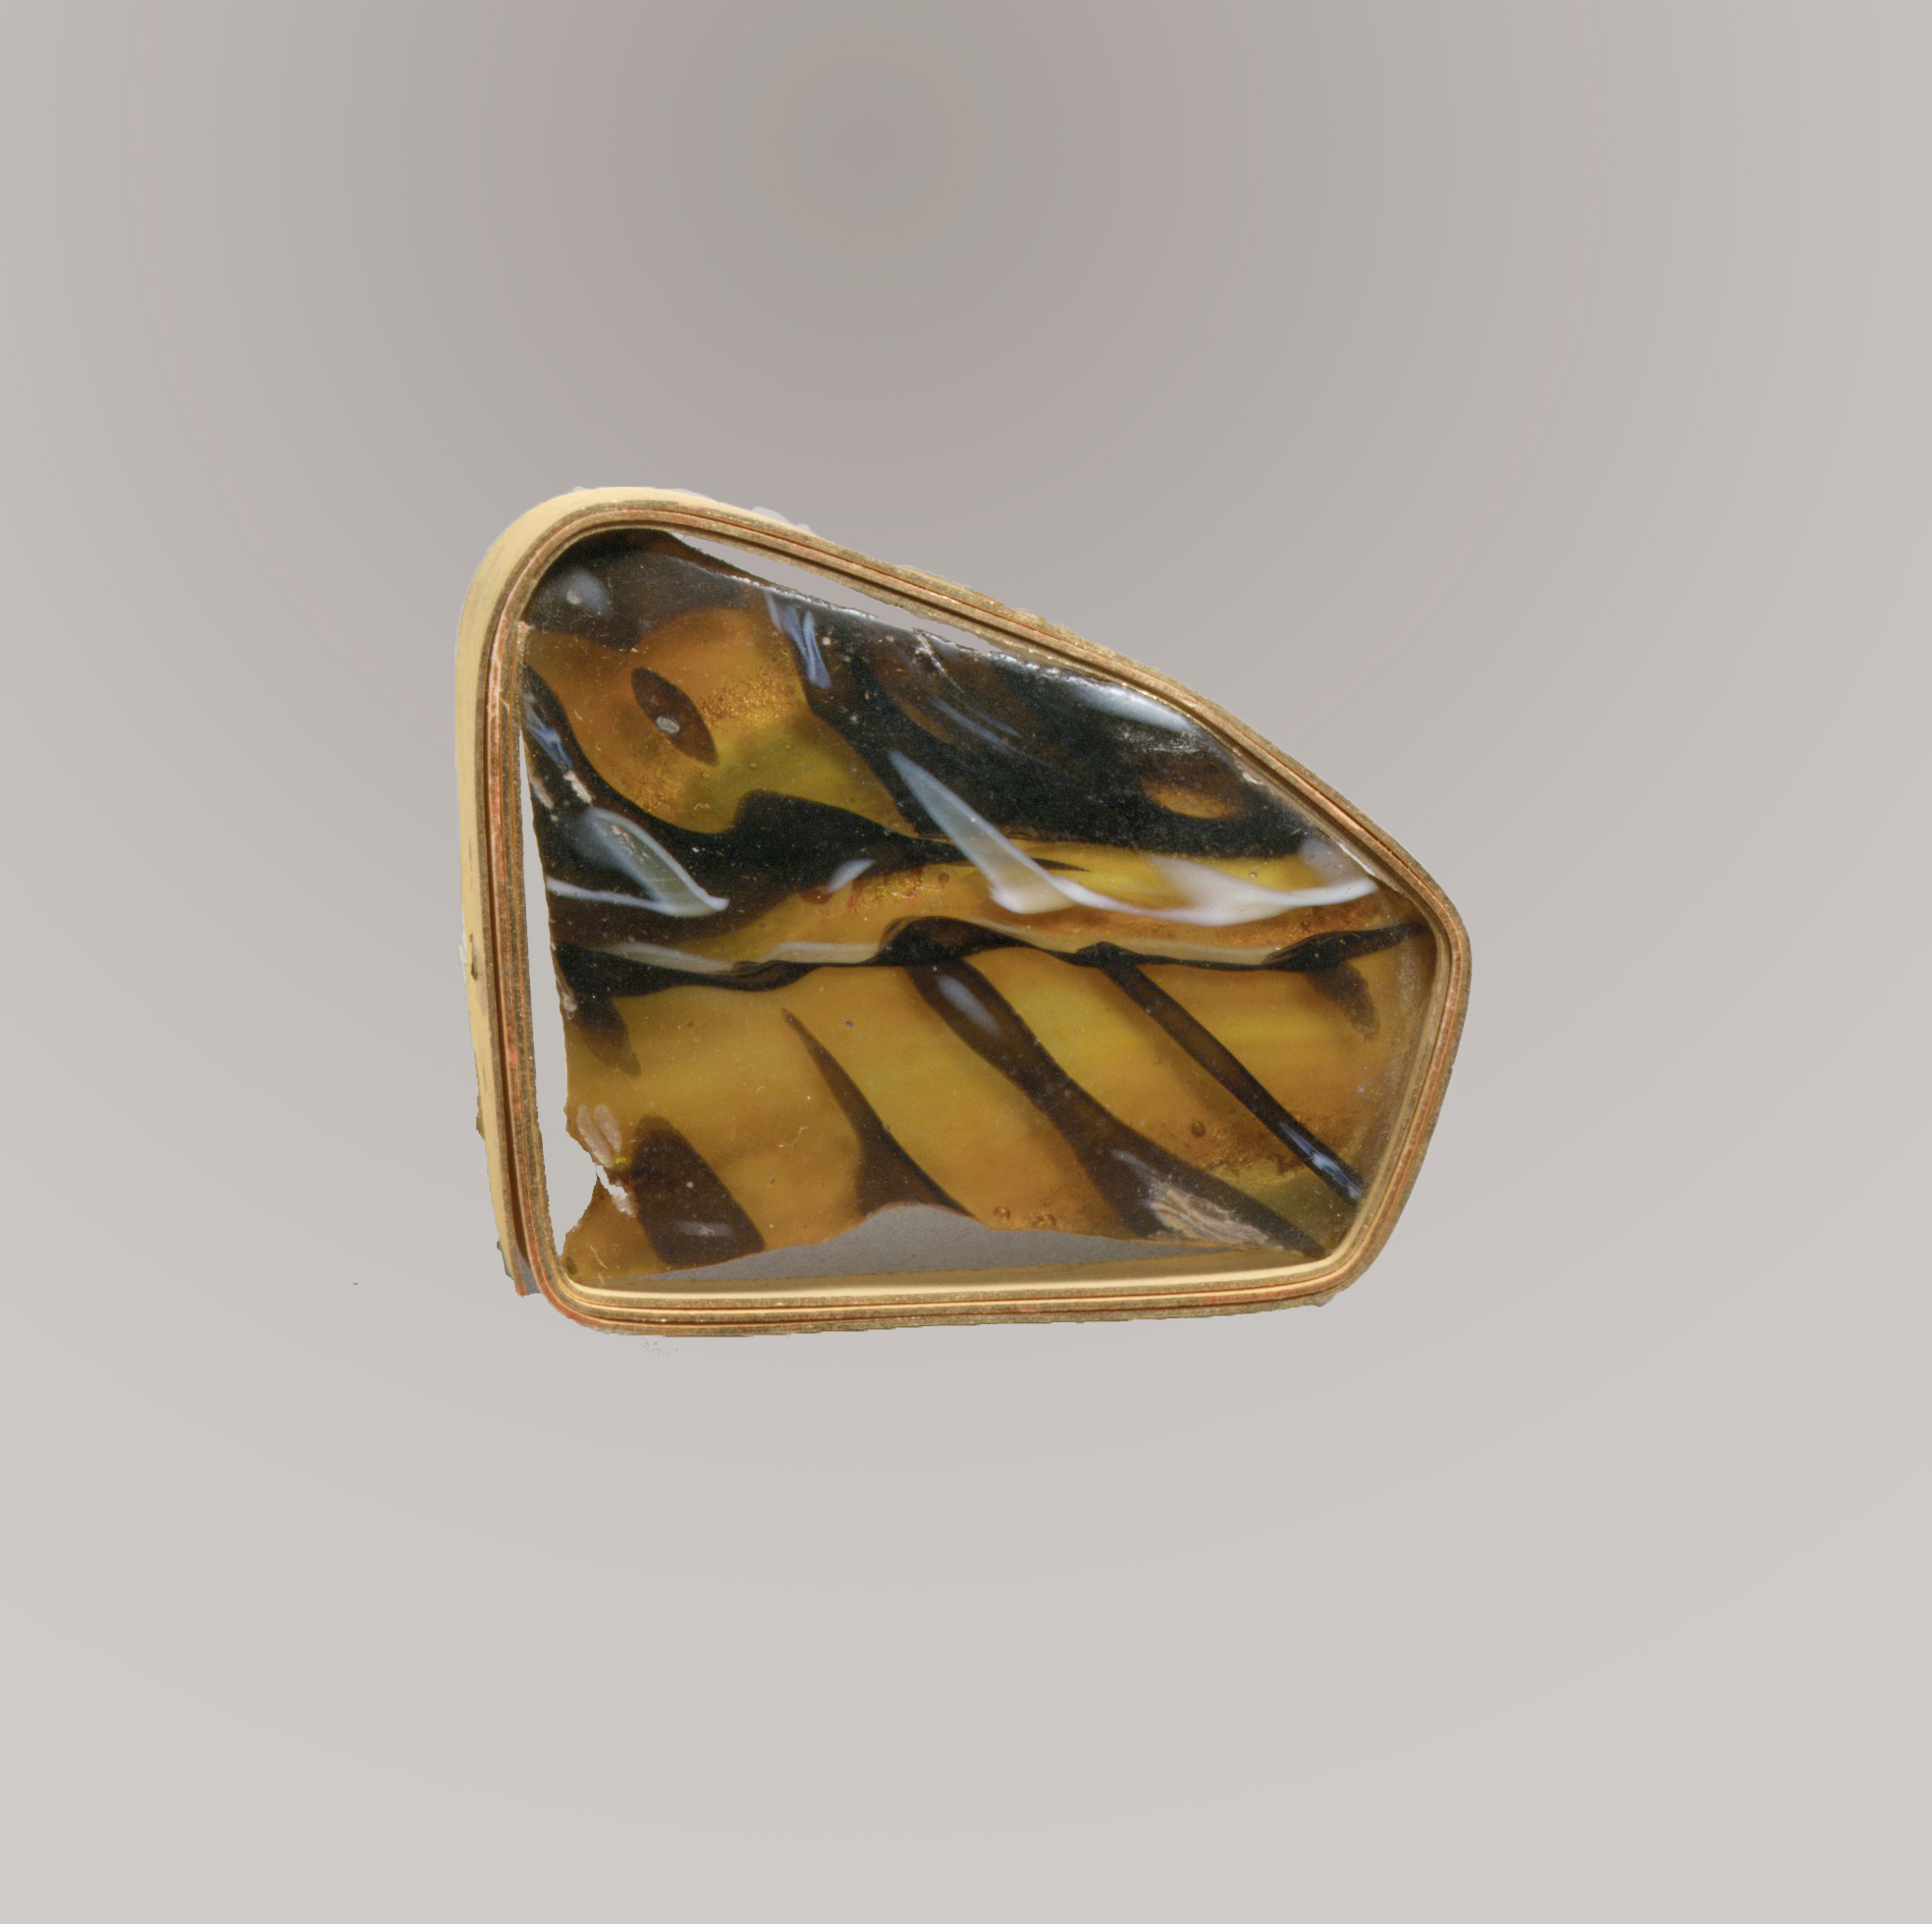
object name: fragment, mosaic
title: Glass mosaic bowl fragment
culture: roman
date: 34 BCE-33 CE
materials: glass